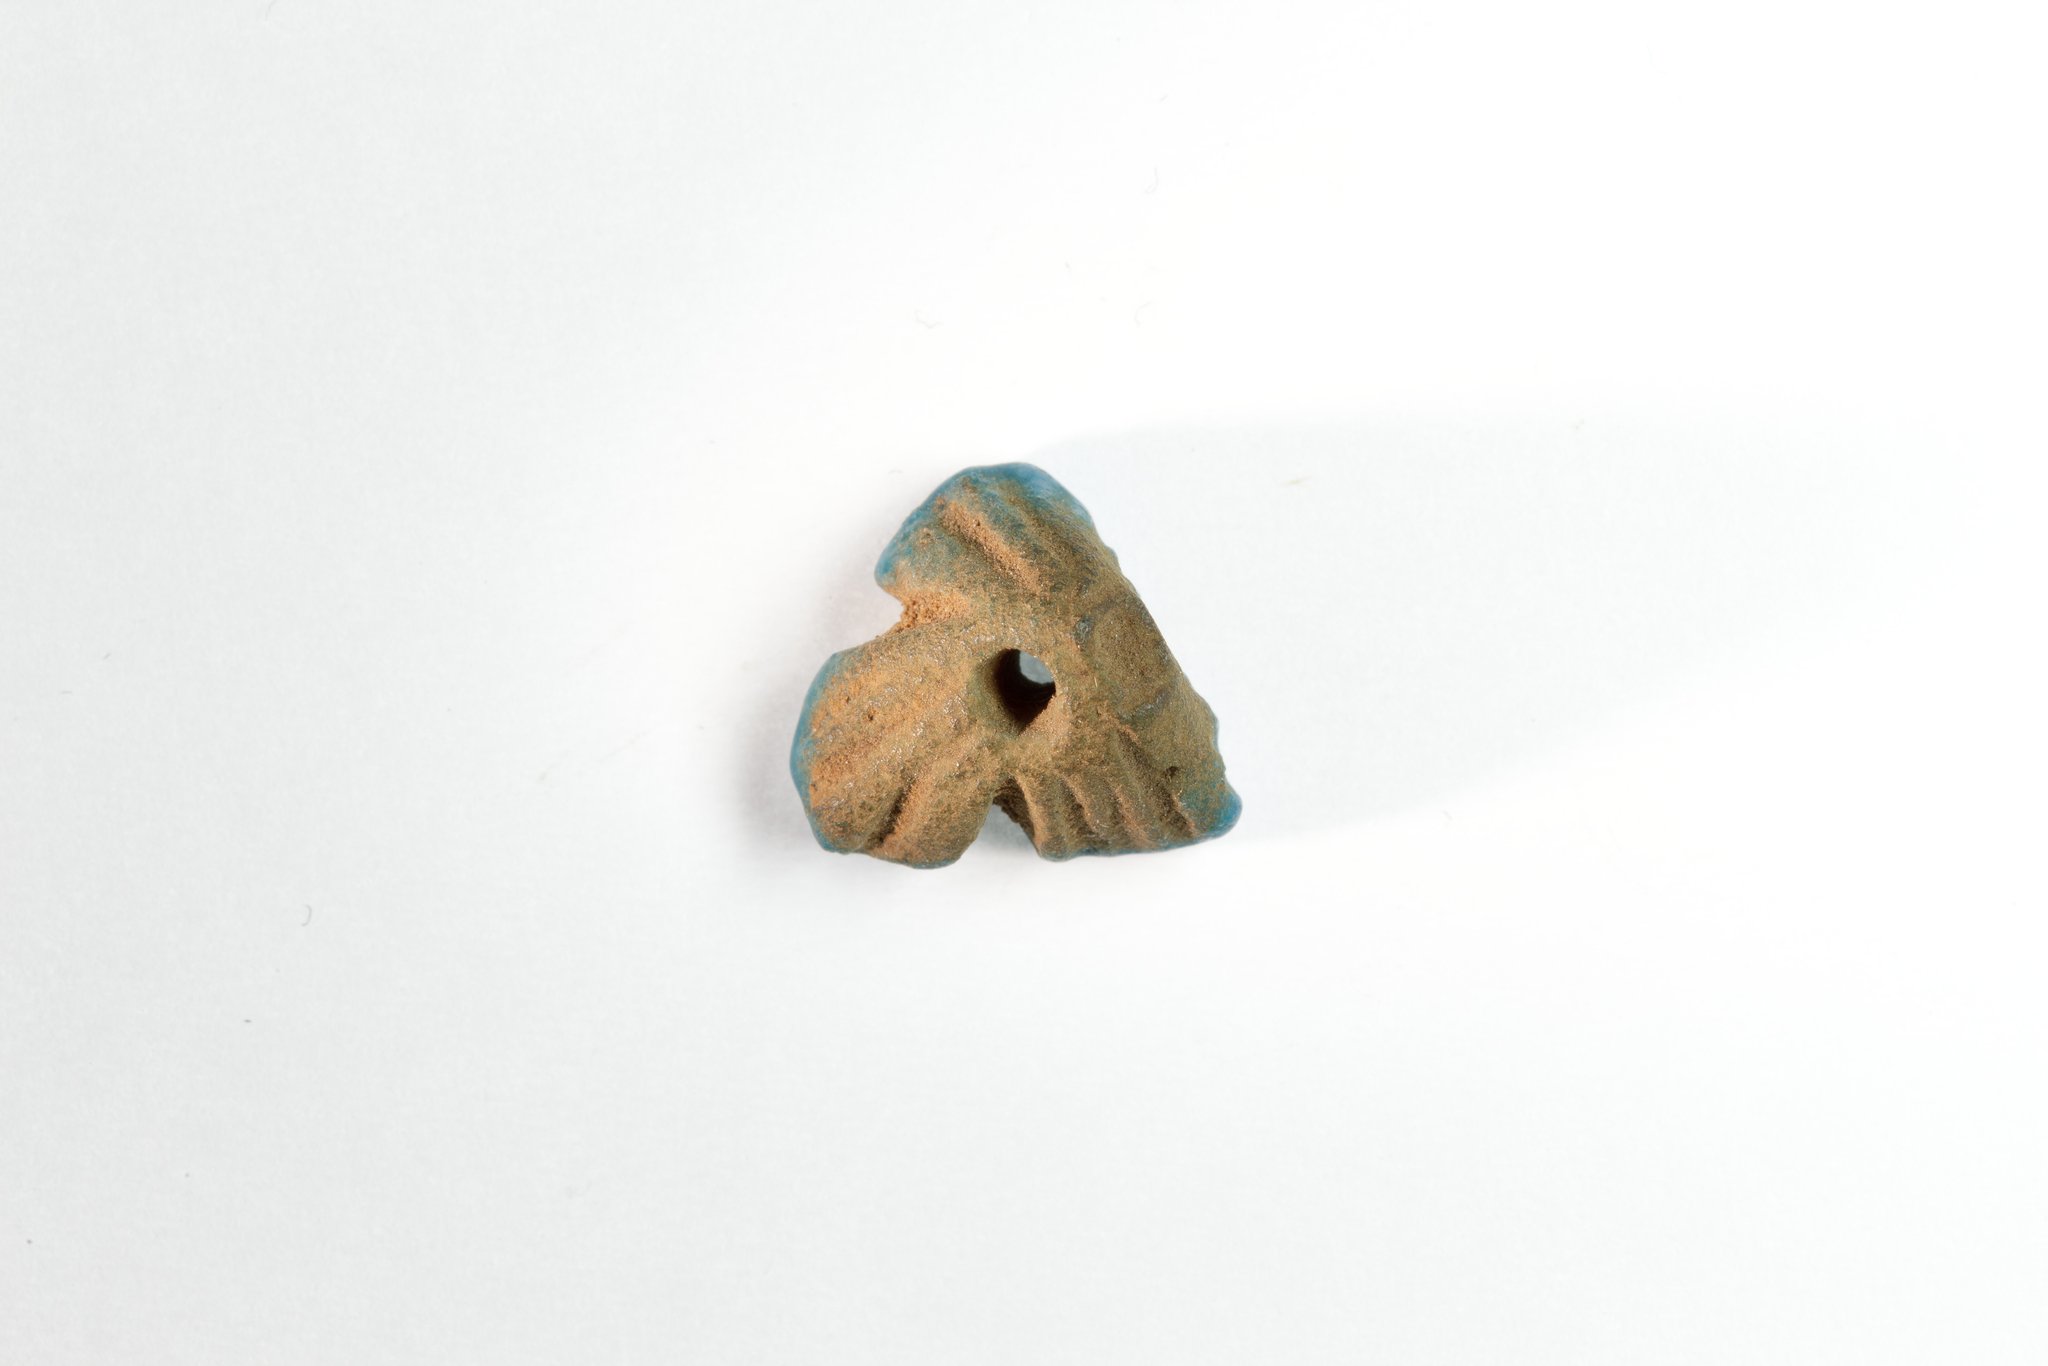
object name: bead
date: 1550-1295 BCE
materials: faience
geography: northern upper egypt